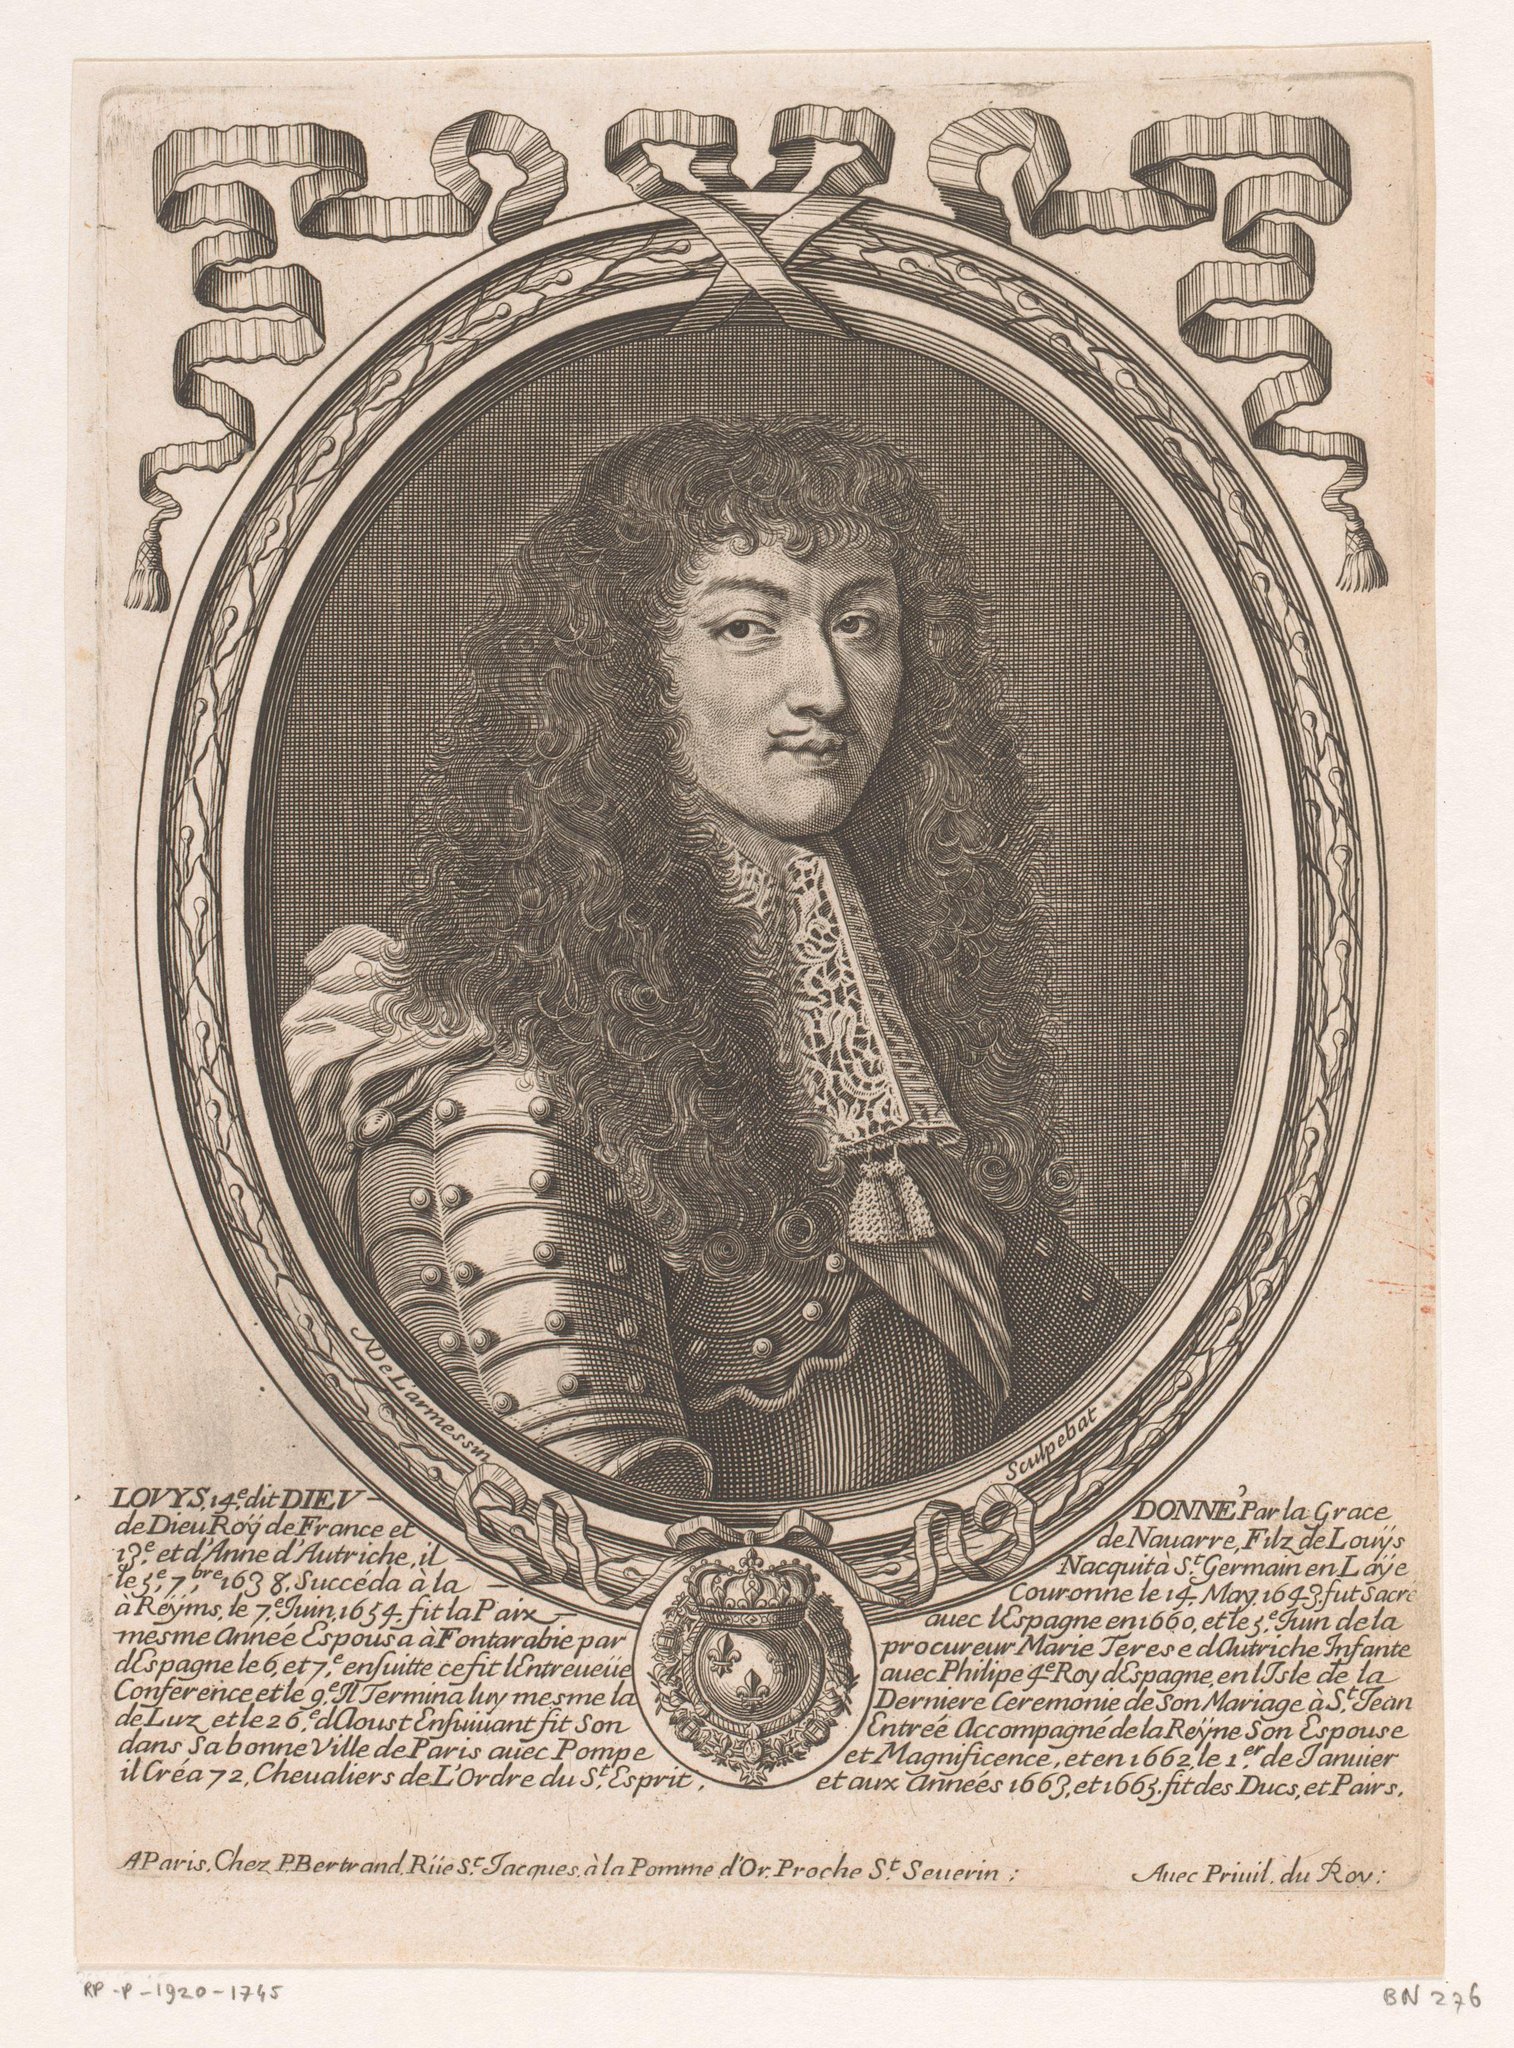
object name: print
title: Portret van Lodewijk XIV, koning van Frankrijk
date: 1642-1678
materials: paper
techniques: engraving, etching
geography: paris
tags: lodewijk xiv (koning van frankrijk), historical persons, king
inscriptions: collector's mark: Lugt 2228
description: Maakt deel uit van een grootschalige serie met portretten van prominente figuren. Binnen de serie bevindt zich een sectie getiteld 'Les Augustes Représentations De tous les Roys De France depuis Pharamond Iusqu'à Louys XIIII'. De serie werd respectievelijk uitgegeven door Pierre Bertrand, door zijn weduwe en door De Larmessin zelf.